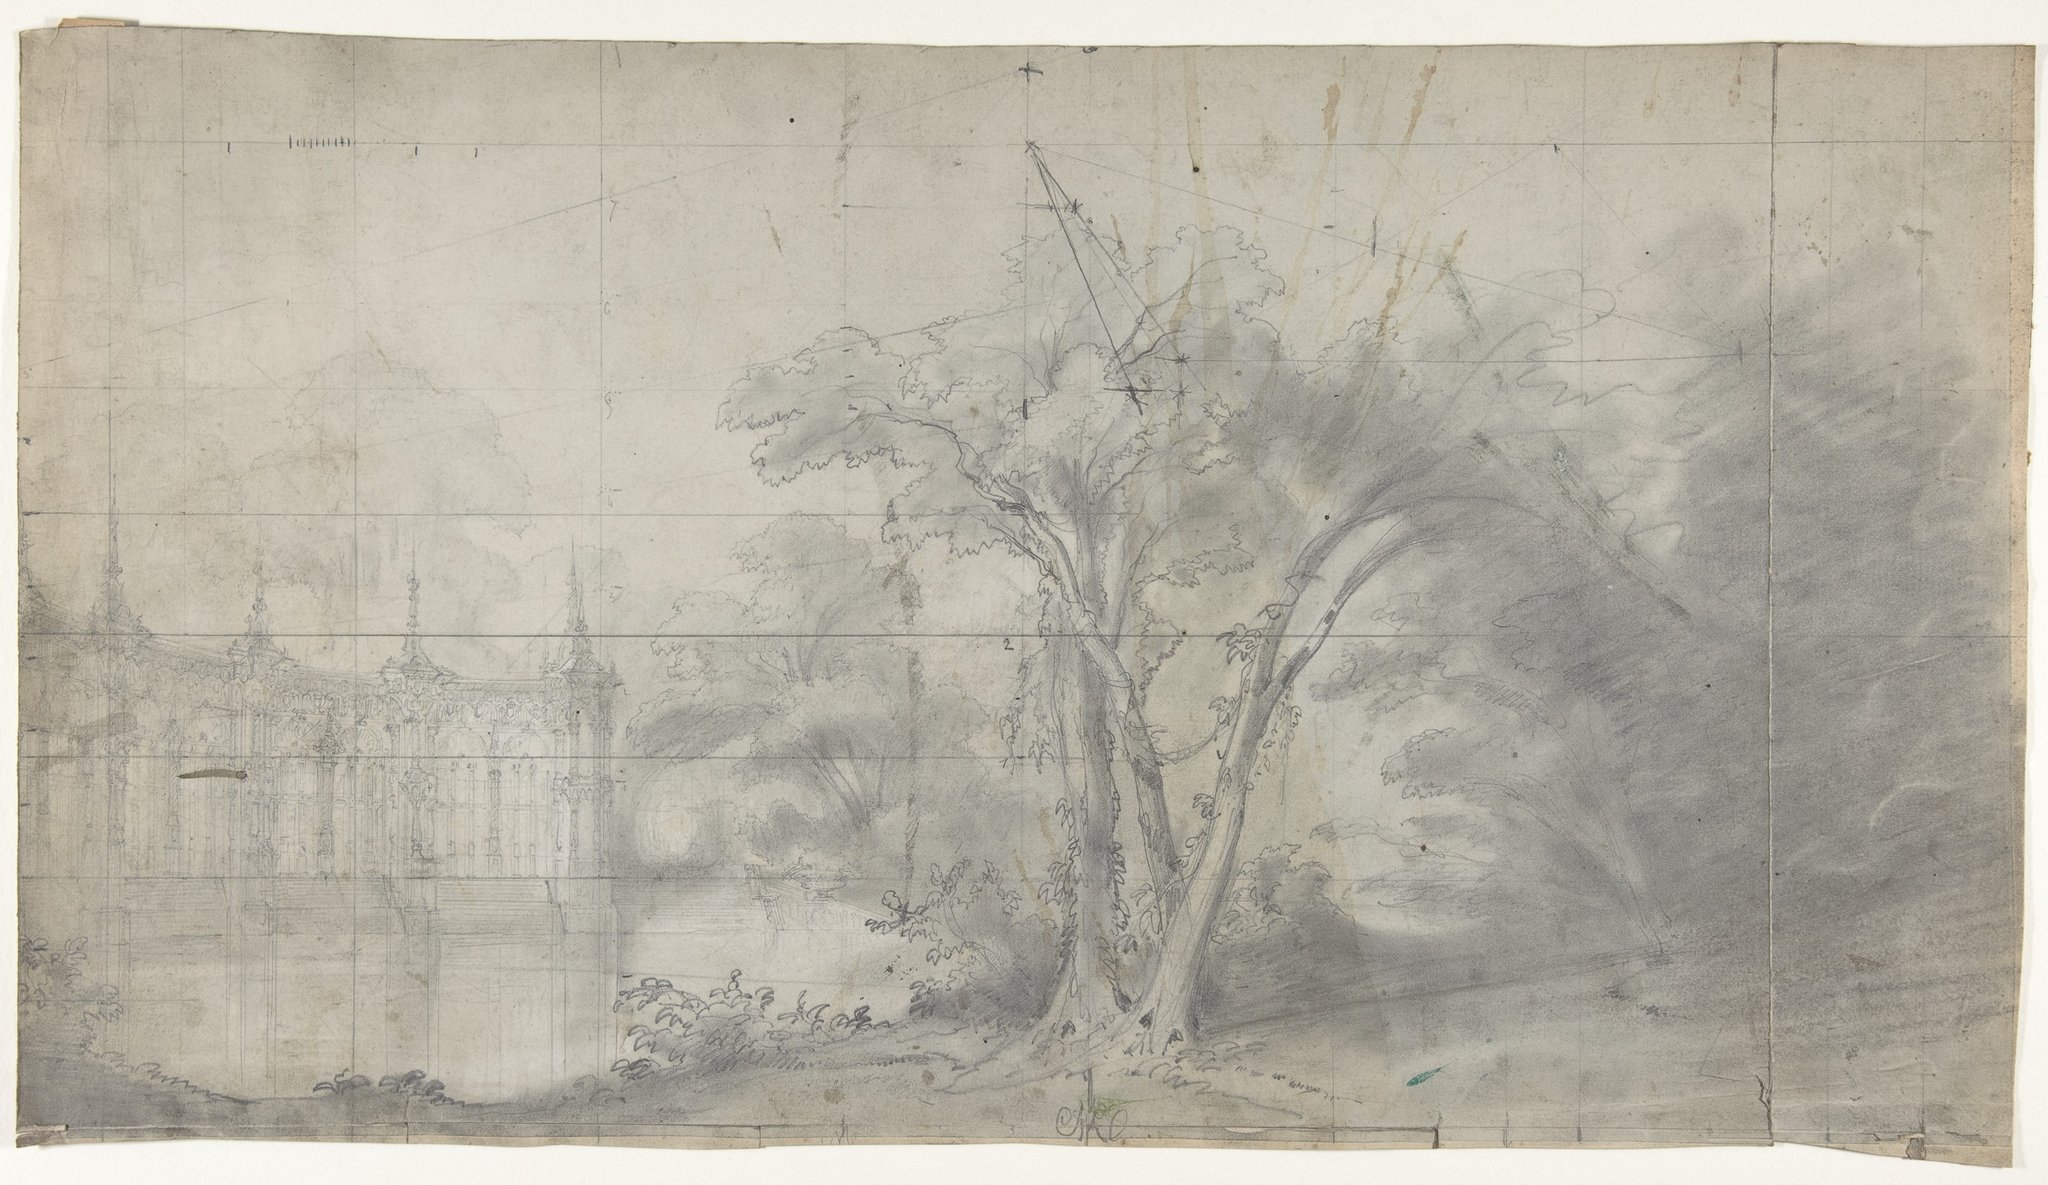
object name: drawing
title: Design for a Stage Set at the Opéra, Paris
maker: eugène cicéri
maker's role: artist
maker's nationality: french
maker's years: 1813-1890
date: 1840-1890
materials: graphite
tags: trees,stage design